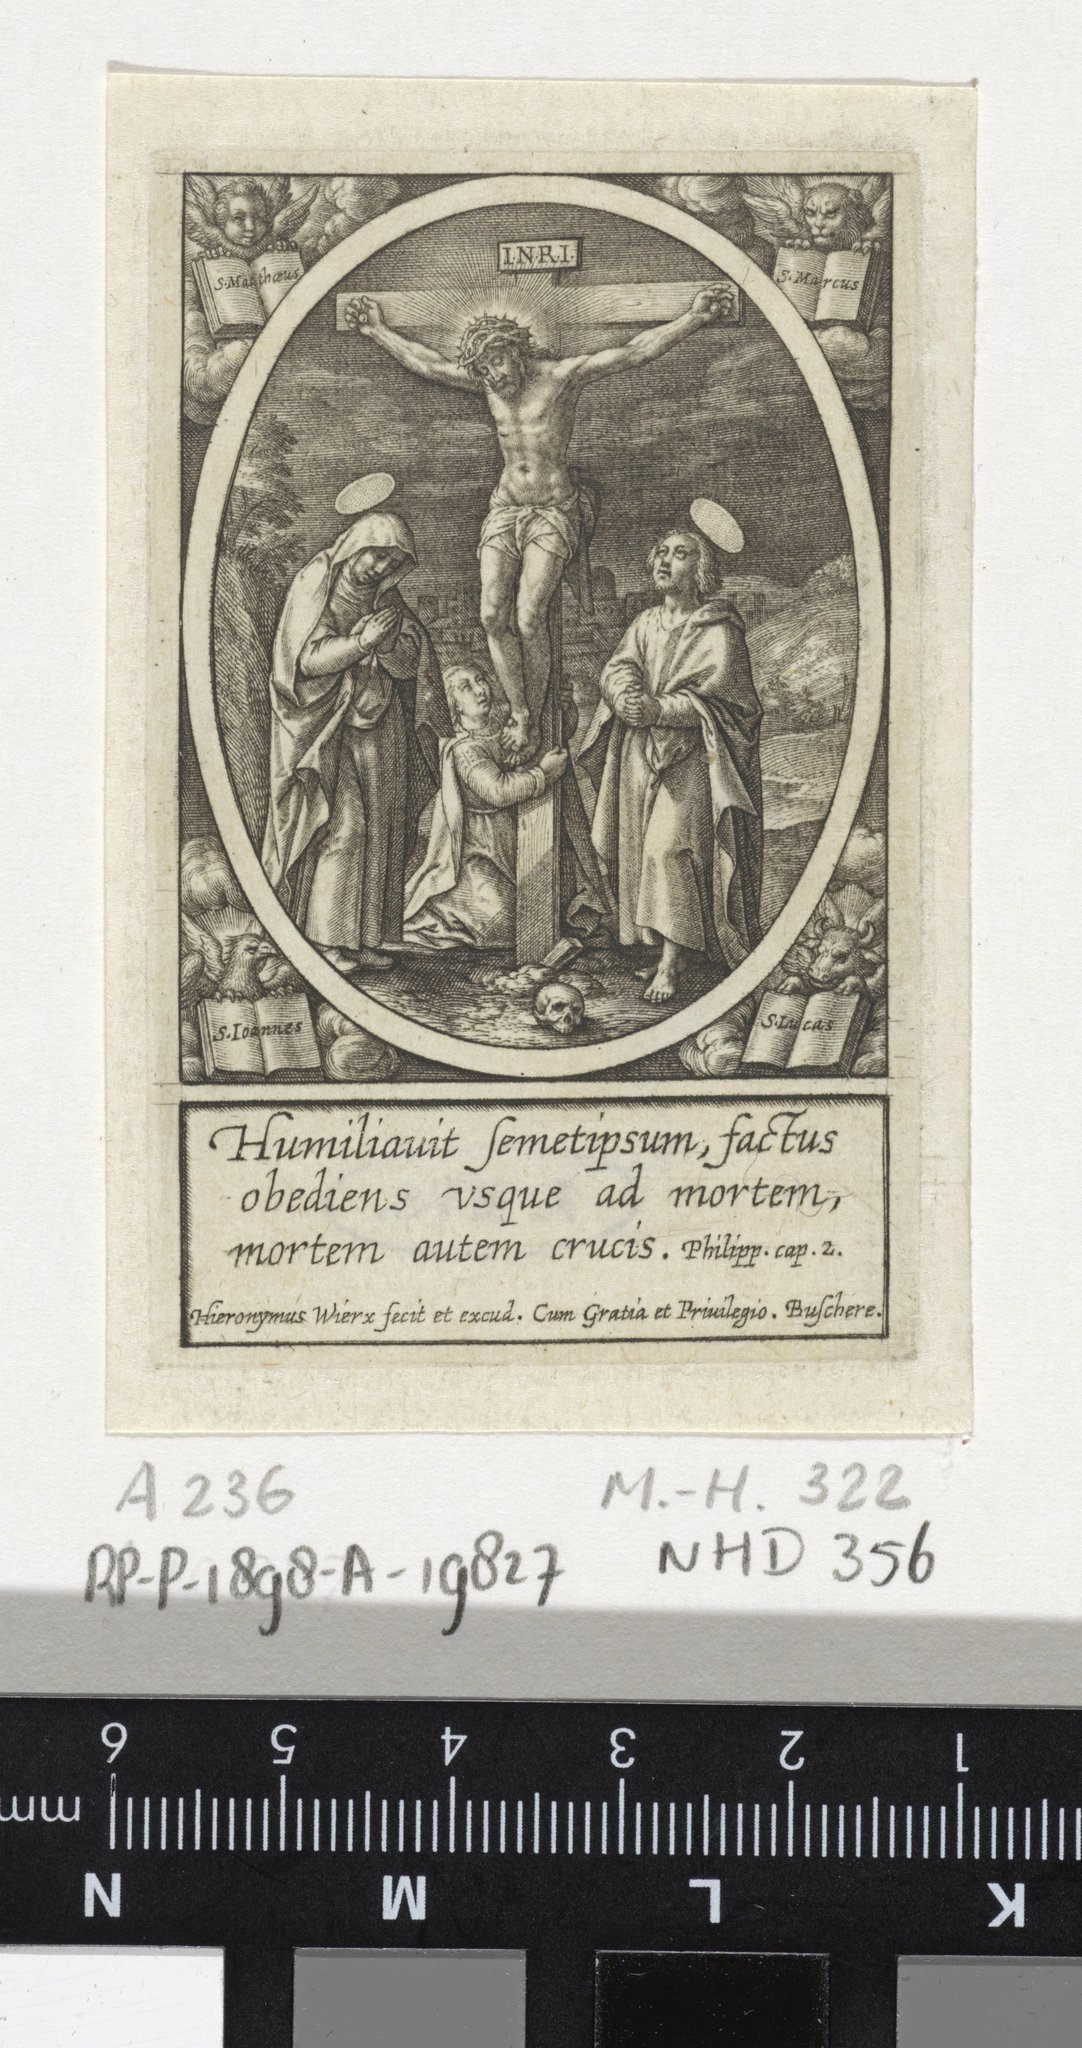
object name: print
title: Kruisiging van Christus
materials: paper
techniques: engraving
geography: antwerp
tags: crucified christ, with particular persons under the cross, the four symbols of the evangelists, 'the apocalyptic beasts'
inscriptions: collector's mark: Lugt 2228, number: ‘236’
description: Kruisdood van Christus op Golgota. Maria Magdalena treurt onder het kruis. Links Maria en rechts Johannes. In de hoeken van de omlijsting de symbolen van de vier evangelisten. In de marge een drieregelig Bijbelcitaat uit Fil. 2 in het Latijn.